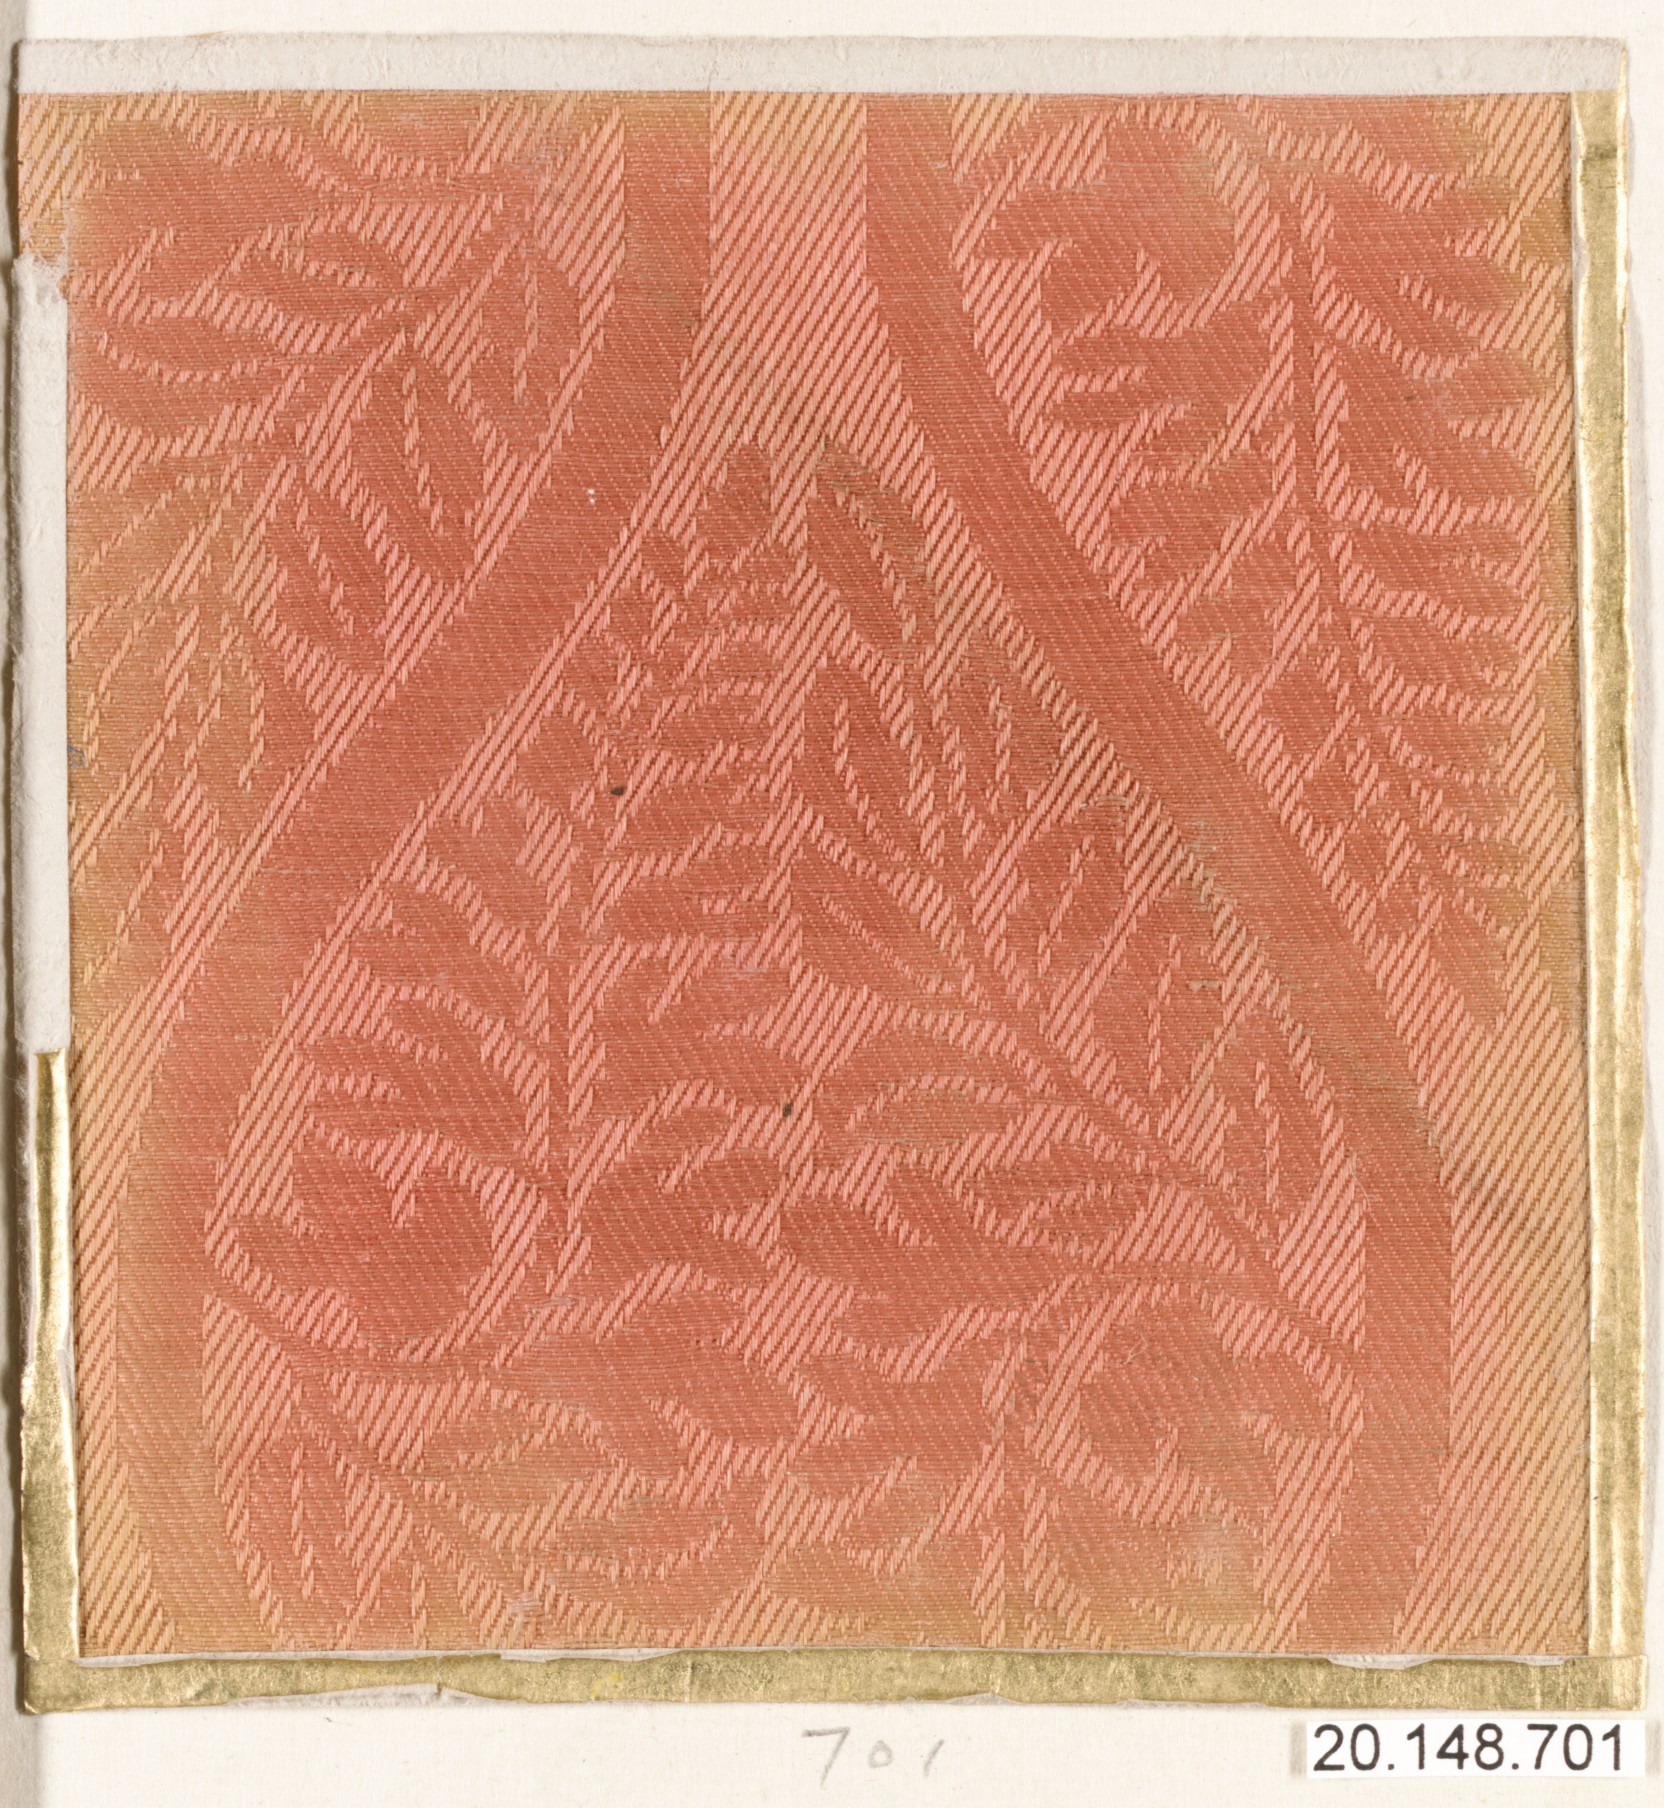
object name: piece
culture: japanese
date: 1701-1800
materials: silk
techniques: compound weave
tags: leaves